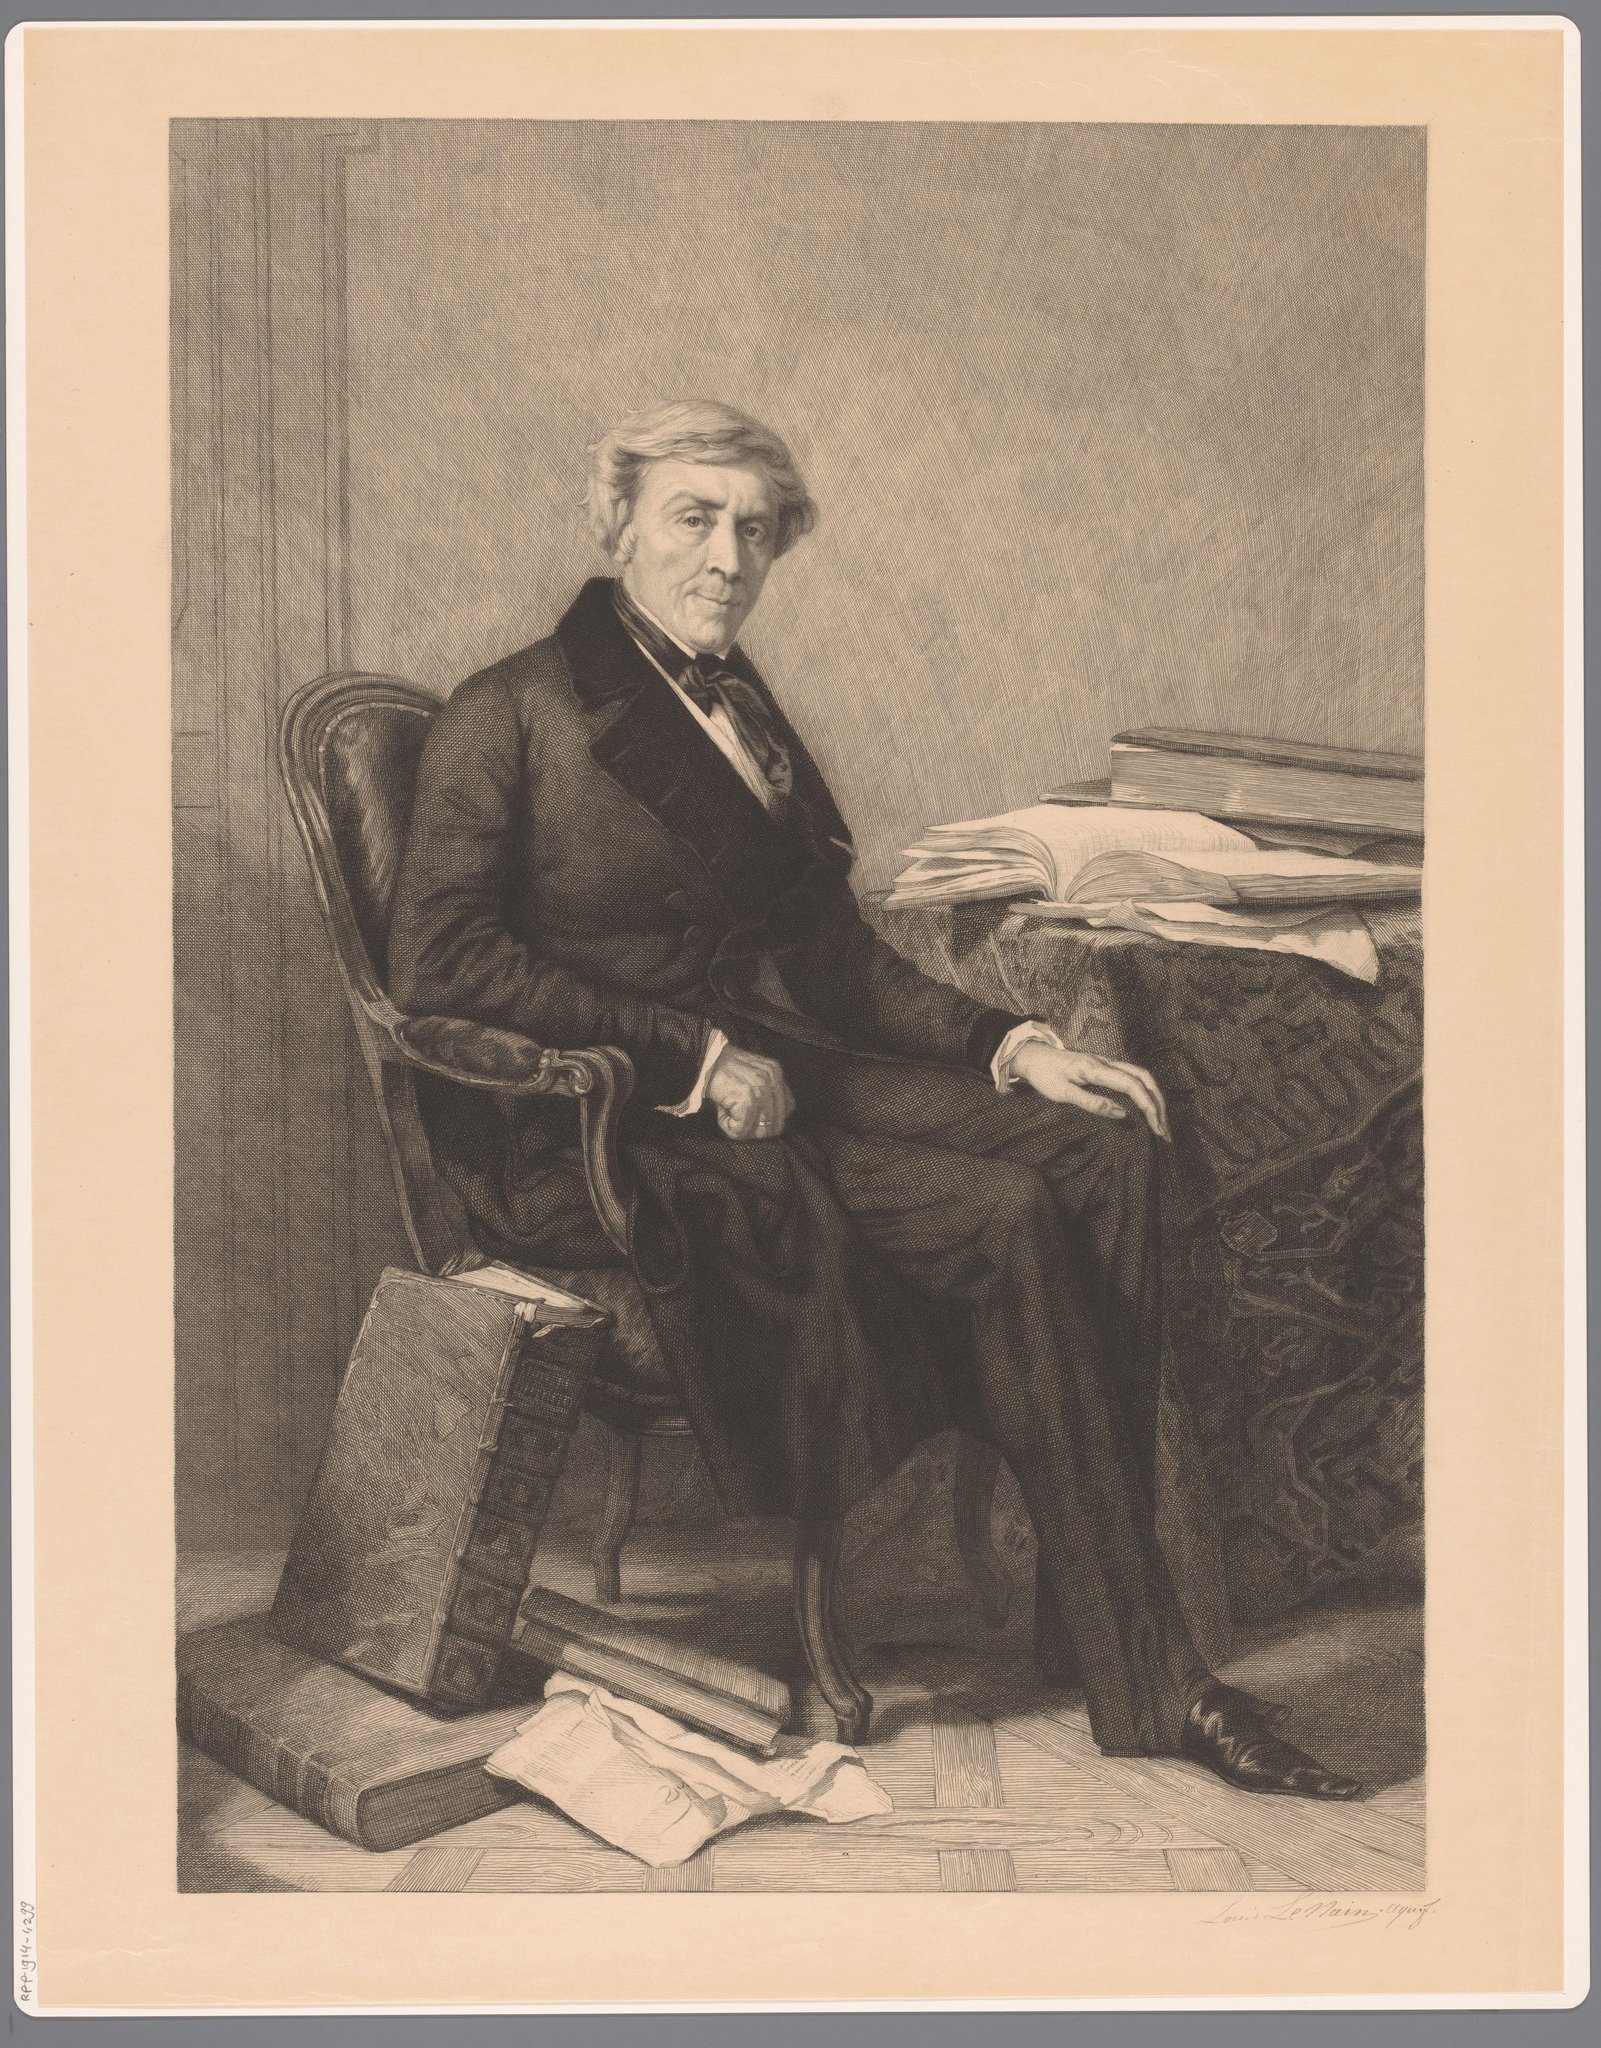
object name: print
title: Portret van een onbekende man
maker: louis le nain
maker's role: print maker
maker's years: 1851-1939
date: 1889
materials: paper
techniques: etching, intaglio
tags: armchair, seat, adult man, historical persons, book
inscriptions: collector's mark: Lugt 2228, inscription: ‘Louis Le Nain aquf.’